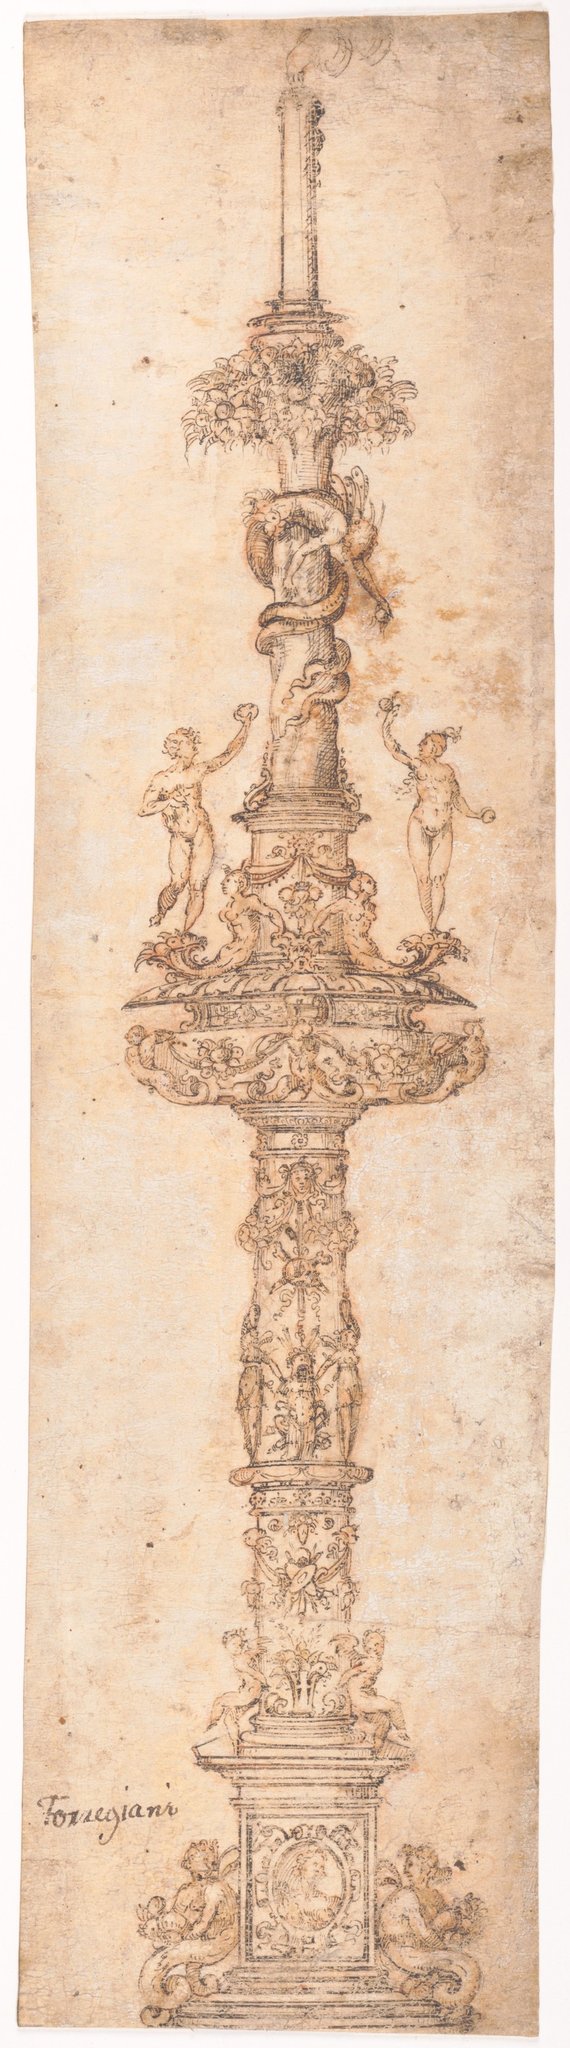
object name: drawing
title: Design for a Candlestick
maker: pietro torrigiano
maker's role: artist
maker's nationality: italian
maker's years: 1472-1528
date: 1472-1528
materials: ink, parchment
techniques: brush, pen, wash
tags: candlesticks